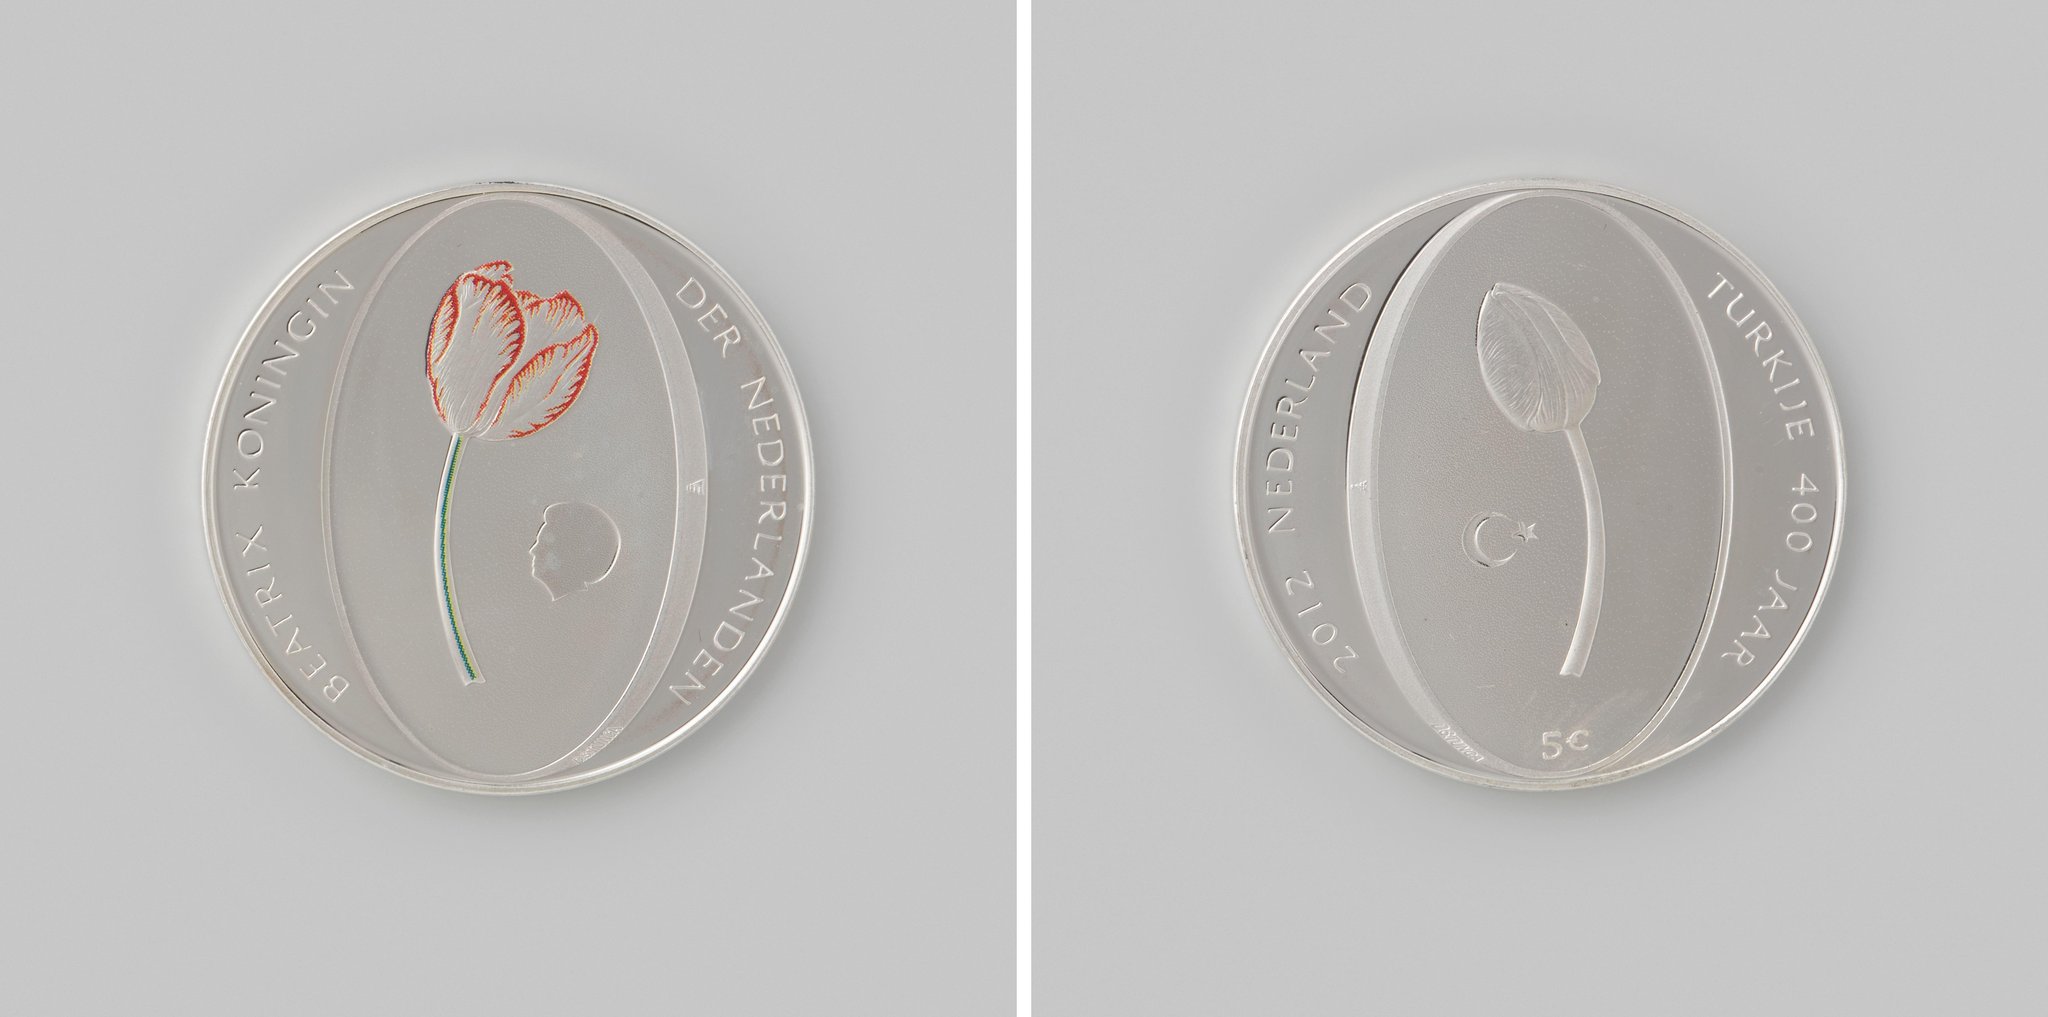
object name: coin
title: Tulpen Vijfje; eerste slag "400 jaar diplomatieke betrekkingen Nederland en Turkije"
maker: deniz seyda tunca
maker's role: vormgever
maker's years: 1973-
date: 2012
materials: silver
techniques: striking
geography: the hague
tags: beatrix (koningin der nederlanden), flowers: tulip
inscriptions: circumscription: ‘2012 Nederland Turkije 400 jaar’, circumscription: ‘Beatrix Koningin der Nederlanden’, edge inscription: ‘God zij met ons’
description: Zilveren munt van 5 euro, geslagen ter gelegenheid van de viering van 400 jaar diplomatieke betrekkingen tussen Nederland en Turkije. Voorzijde: rode tulp met groene steel, met rechts daarnaast een klein silhouetportret van een vrouw (koningin Beatrix), het geheel binnen een in perspectief weergegeven ovaal (bedoeld als munt in een munt), met omschrift "Beatrix Koningin der Nederlanden". Keerzijde: gesloten tulp met links daarnaast een maansikkel met een ster (wapen van Turkije), het geheel binnen een in perspectief weergegeven ovaal, met omschrift "2012 Nederland Turkije 400 jaar". Randschrift: "God zij met ons".